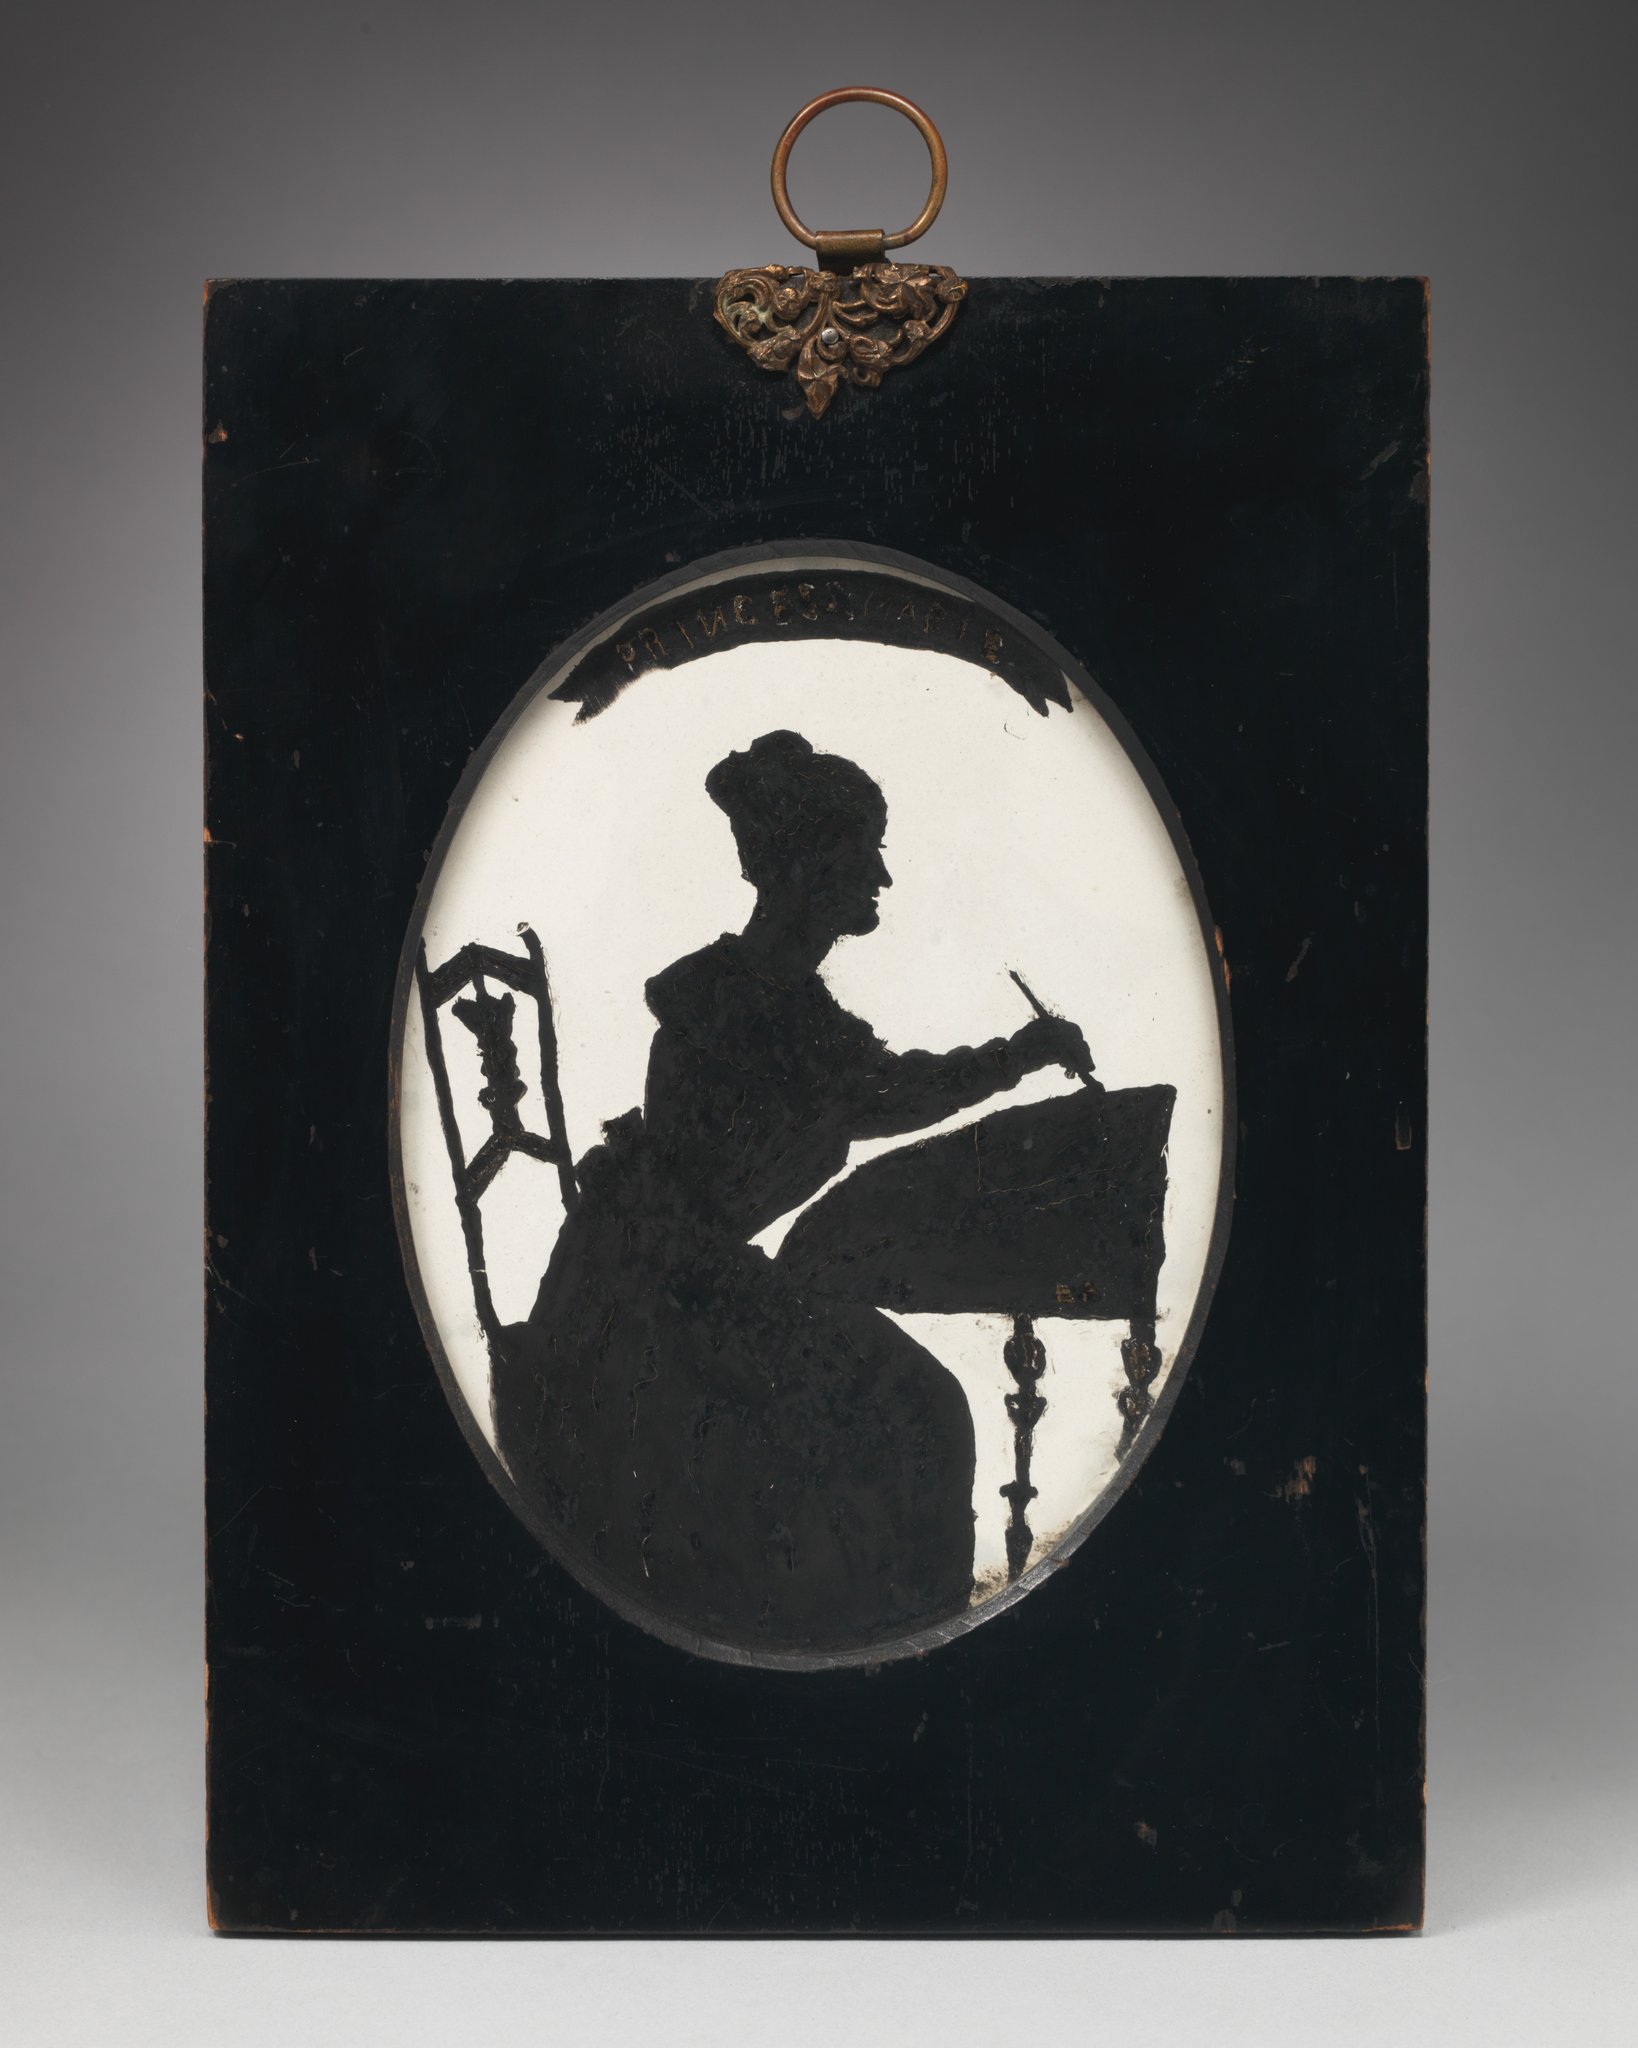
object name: plaque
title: Portrait of Princess Marie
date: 1801-1900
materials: glass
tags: portraits,women,writing